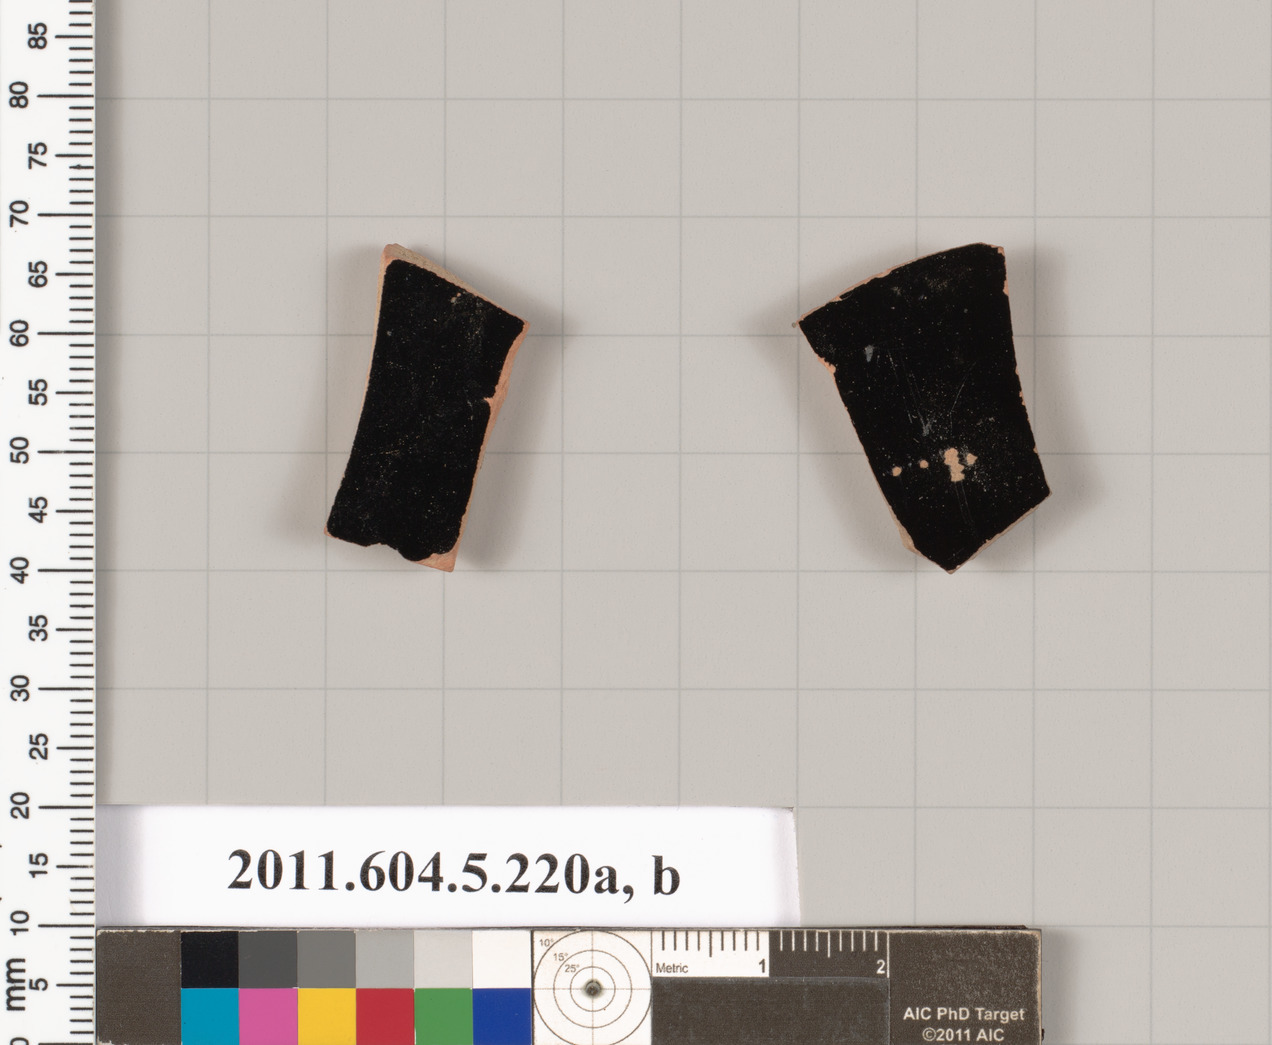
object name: kylix fragment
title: Terracotta fragments of kylikes (drinking cups)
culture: greek, attic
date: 600-401 BCE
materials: terracotta